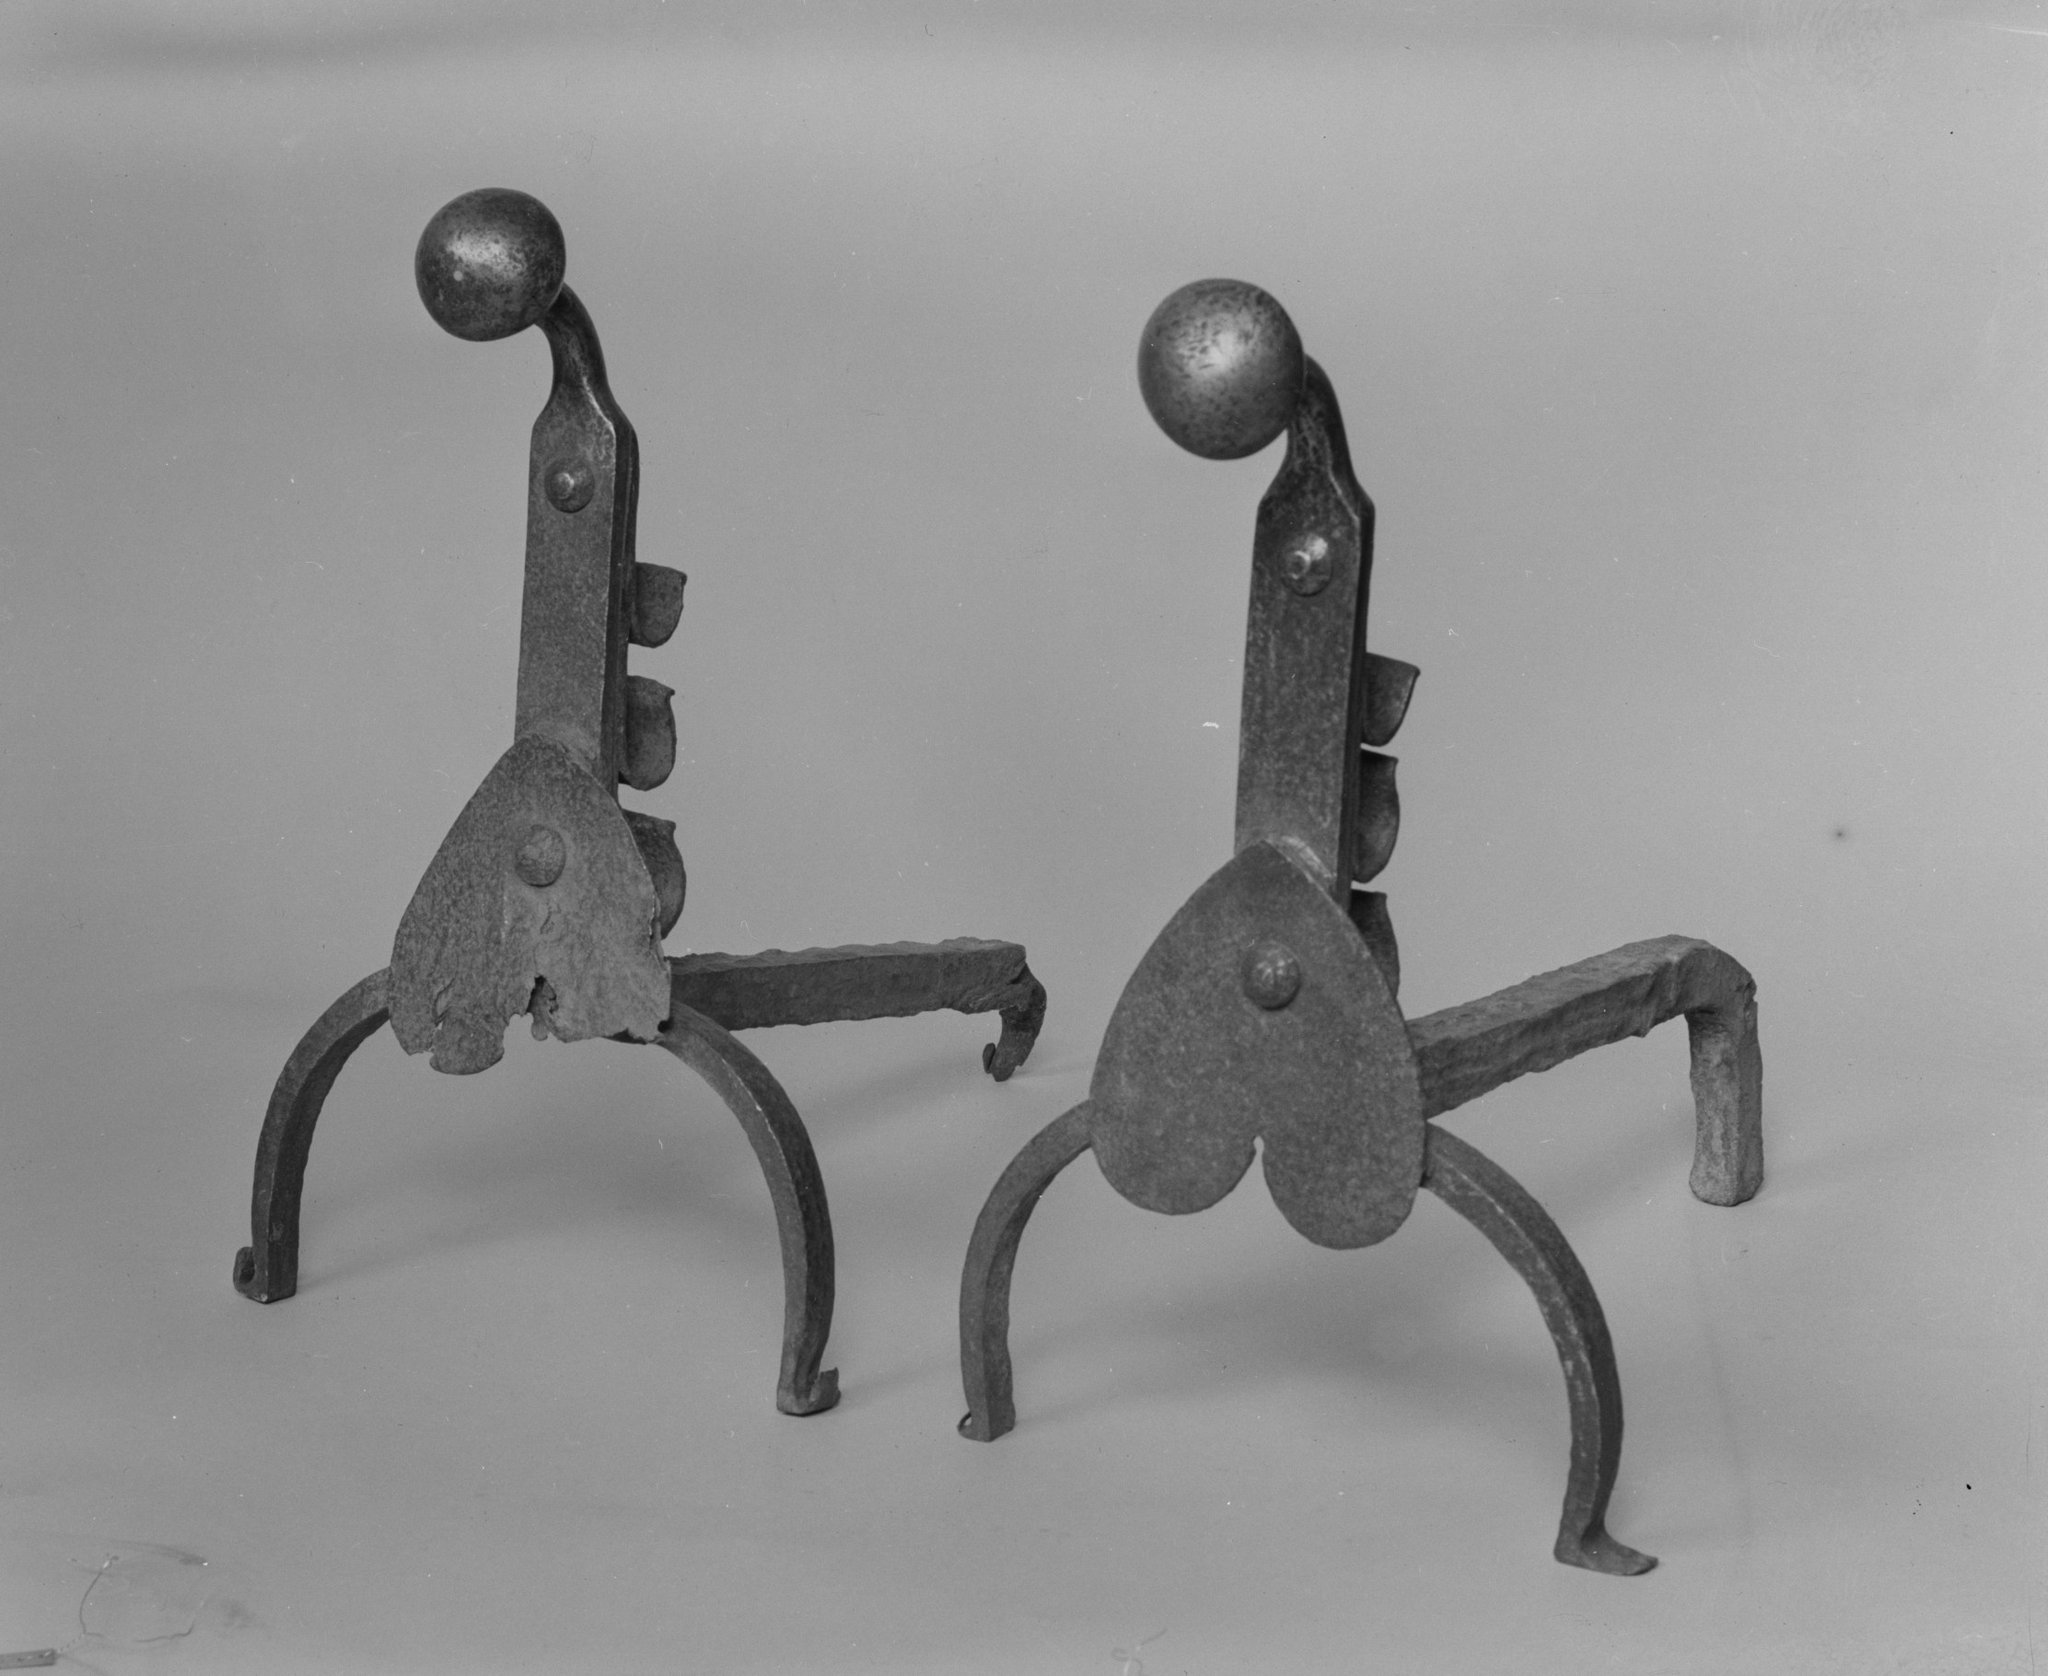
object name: andiron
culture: american or british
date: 1700-1800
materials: iron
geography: england